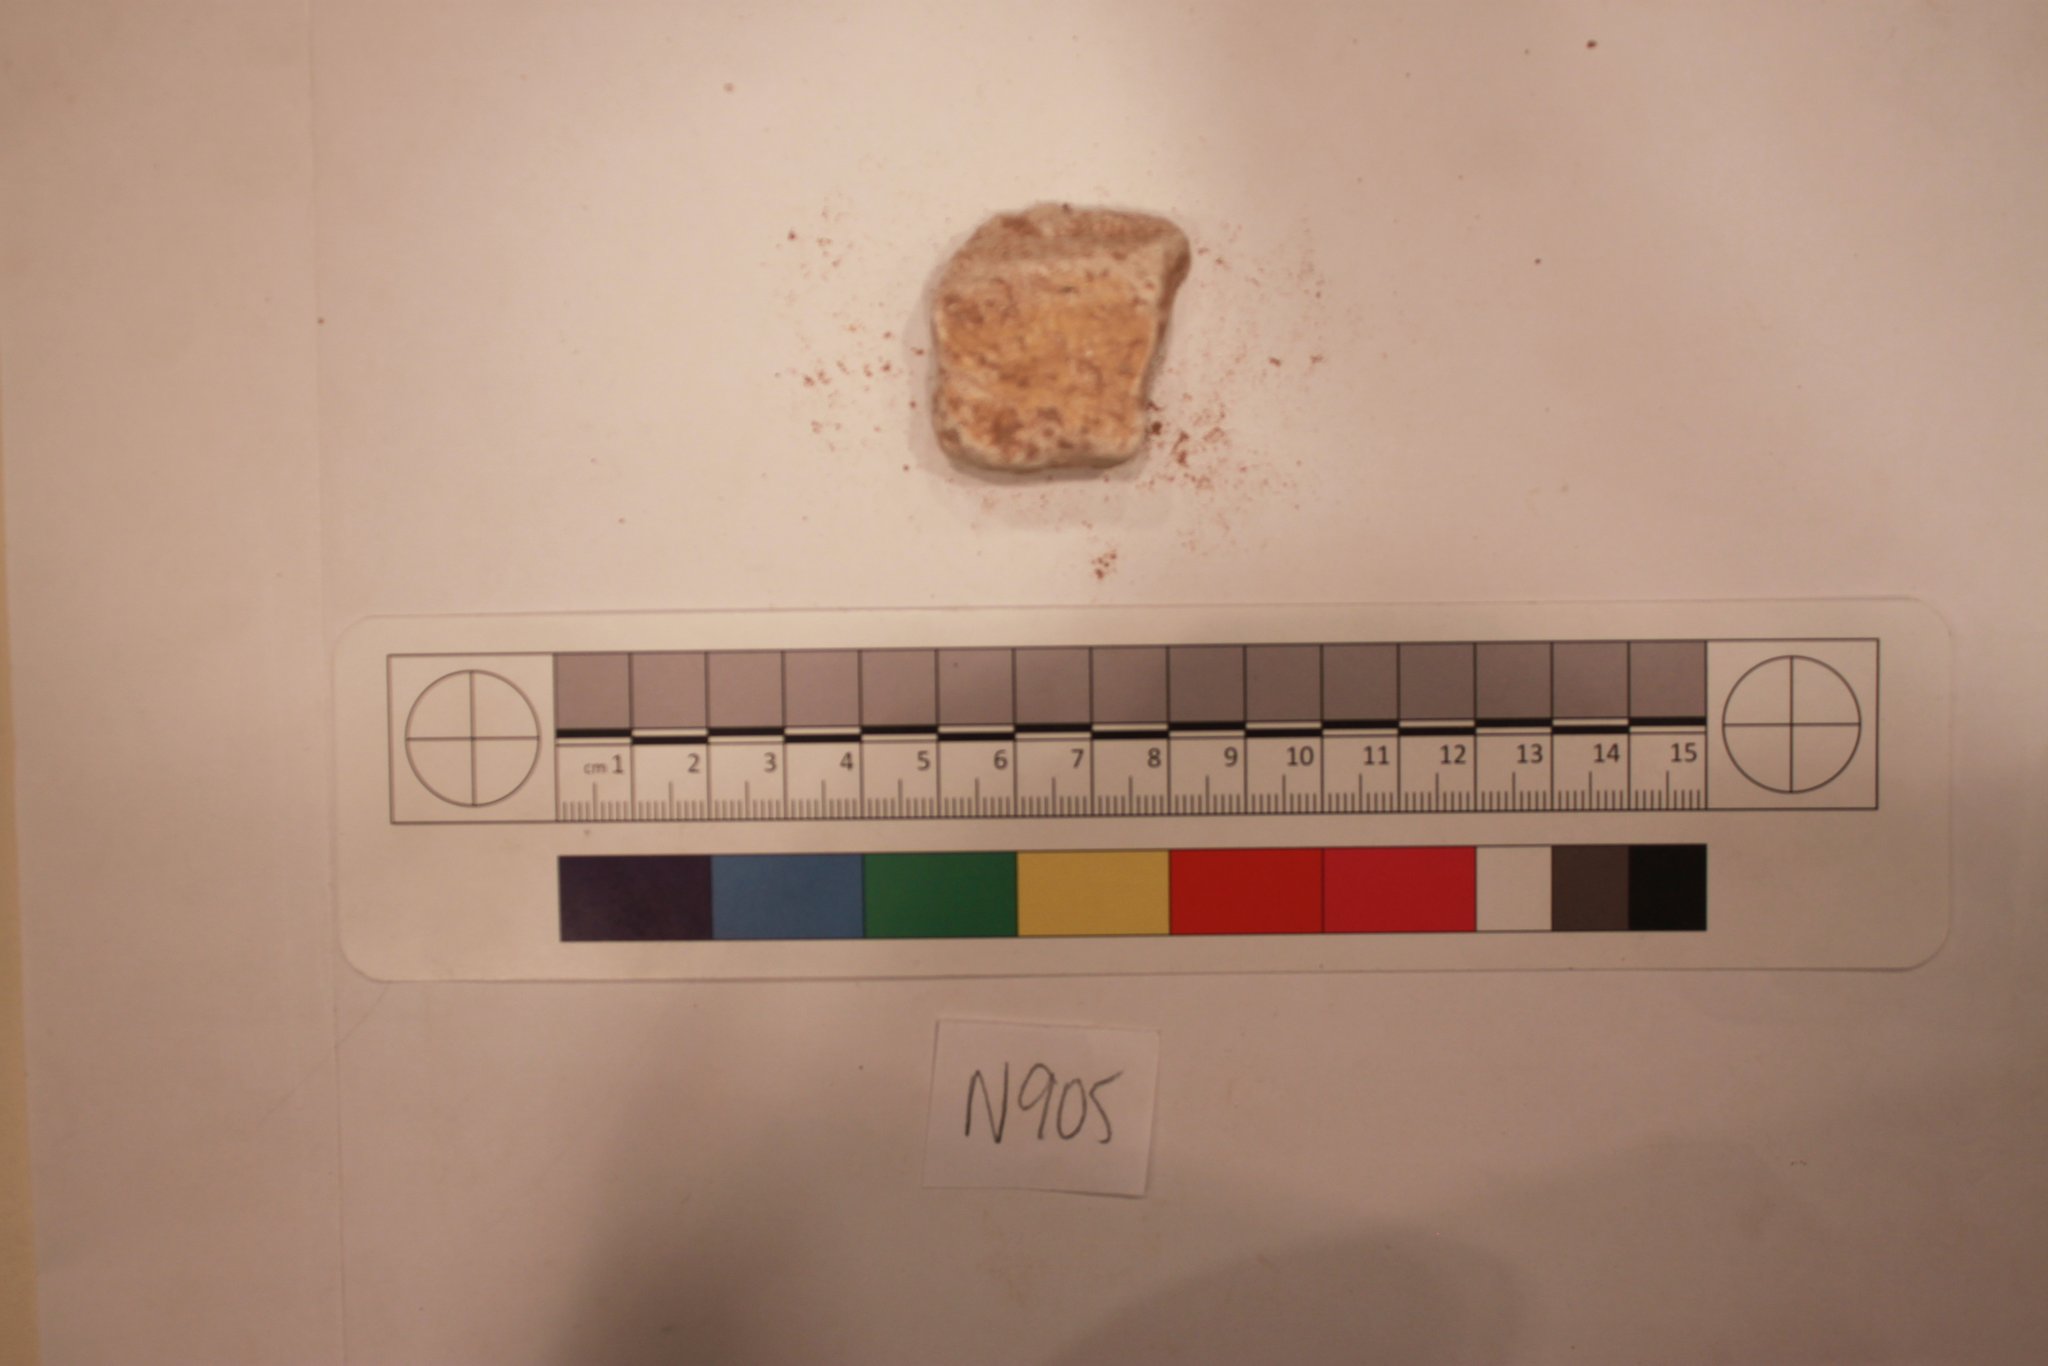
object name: fragment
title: Stucco Fragment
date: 701-1200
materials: plaster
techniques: carving, painting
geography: iran